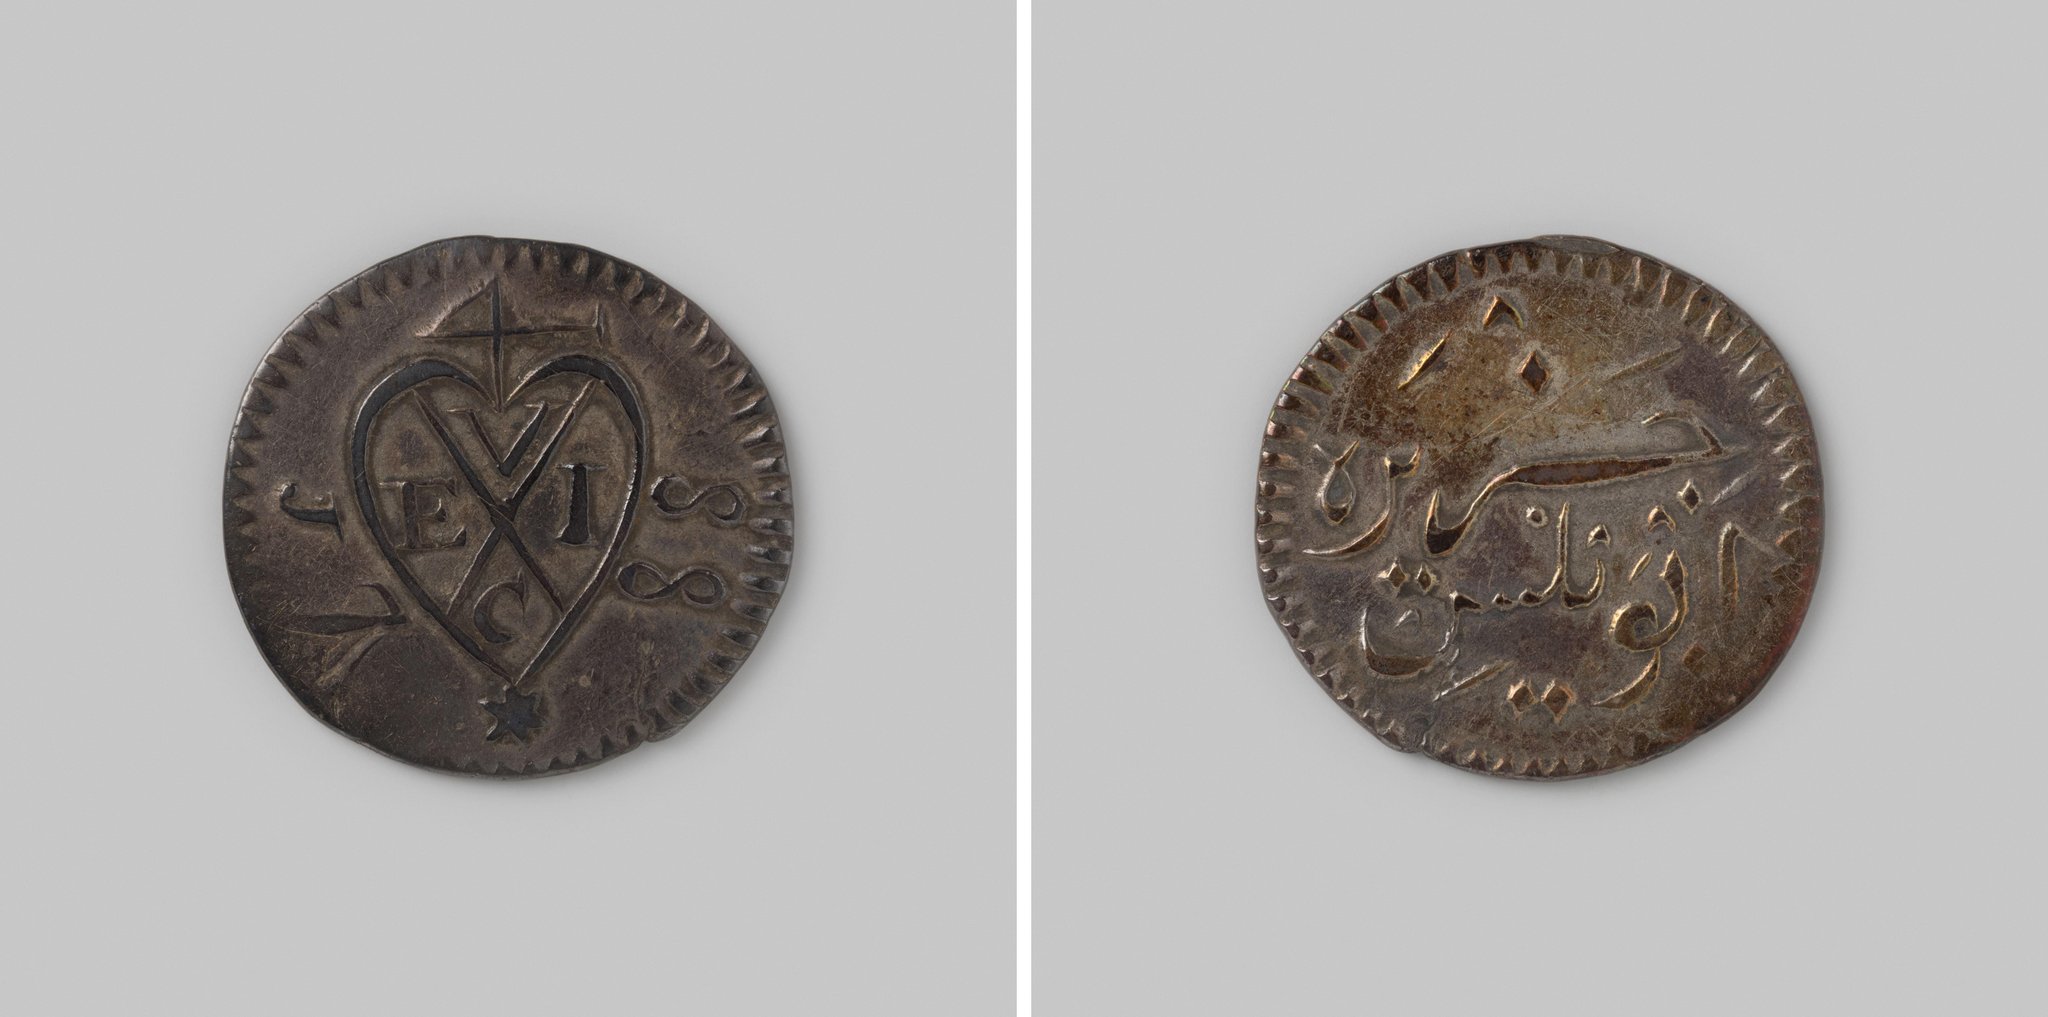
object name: coin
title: Malakka, Prince of Wales Island of Pulu Penang, 1/10 dollar, 1788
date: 1788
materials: silver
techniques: striking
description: Zilveren munt. Voorzijde: hartvormig merk van de Engelse Oostindische Compagnie (EIC), waaronder ster. Jaartal ter weerzijden van het merk. Keerzijde: drieregelig opschrift in Arabische lettertekens: jezirah prins abwails. Gladde rand.